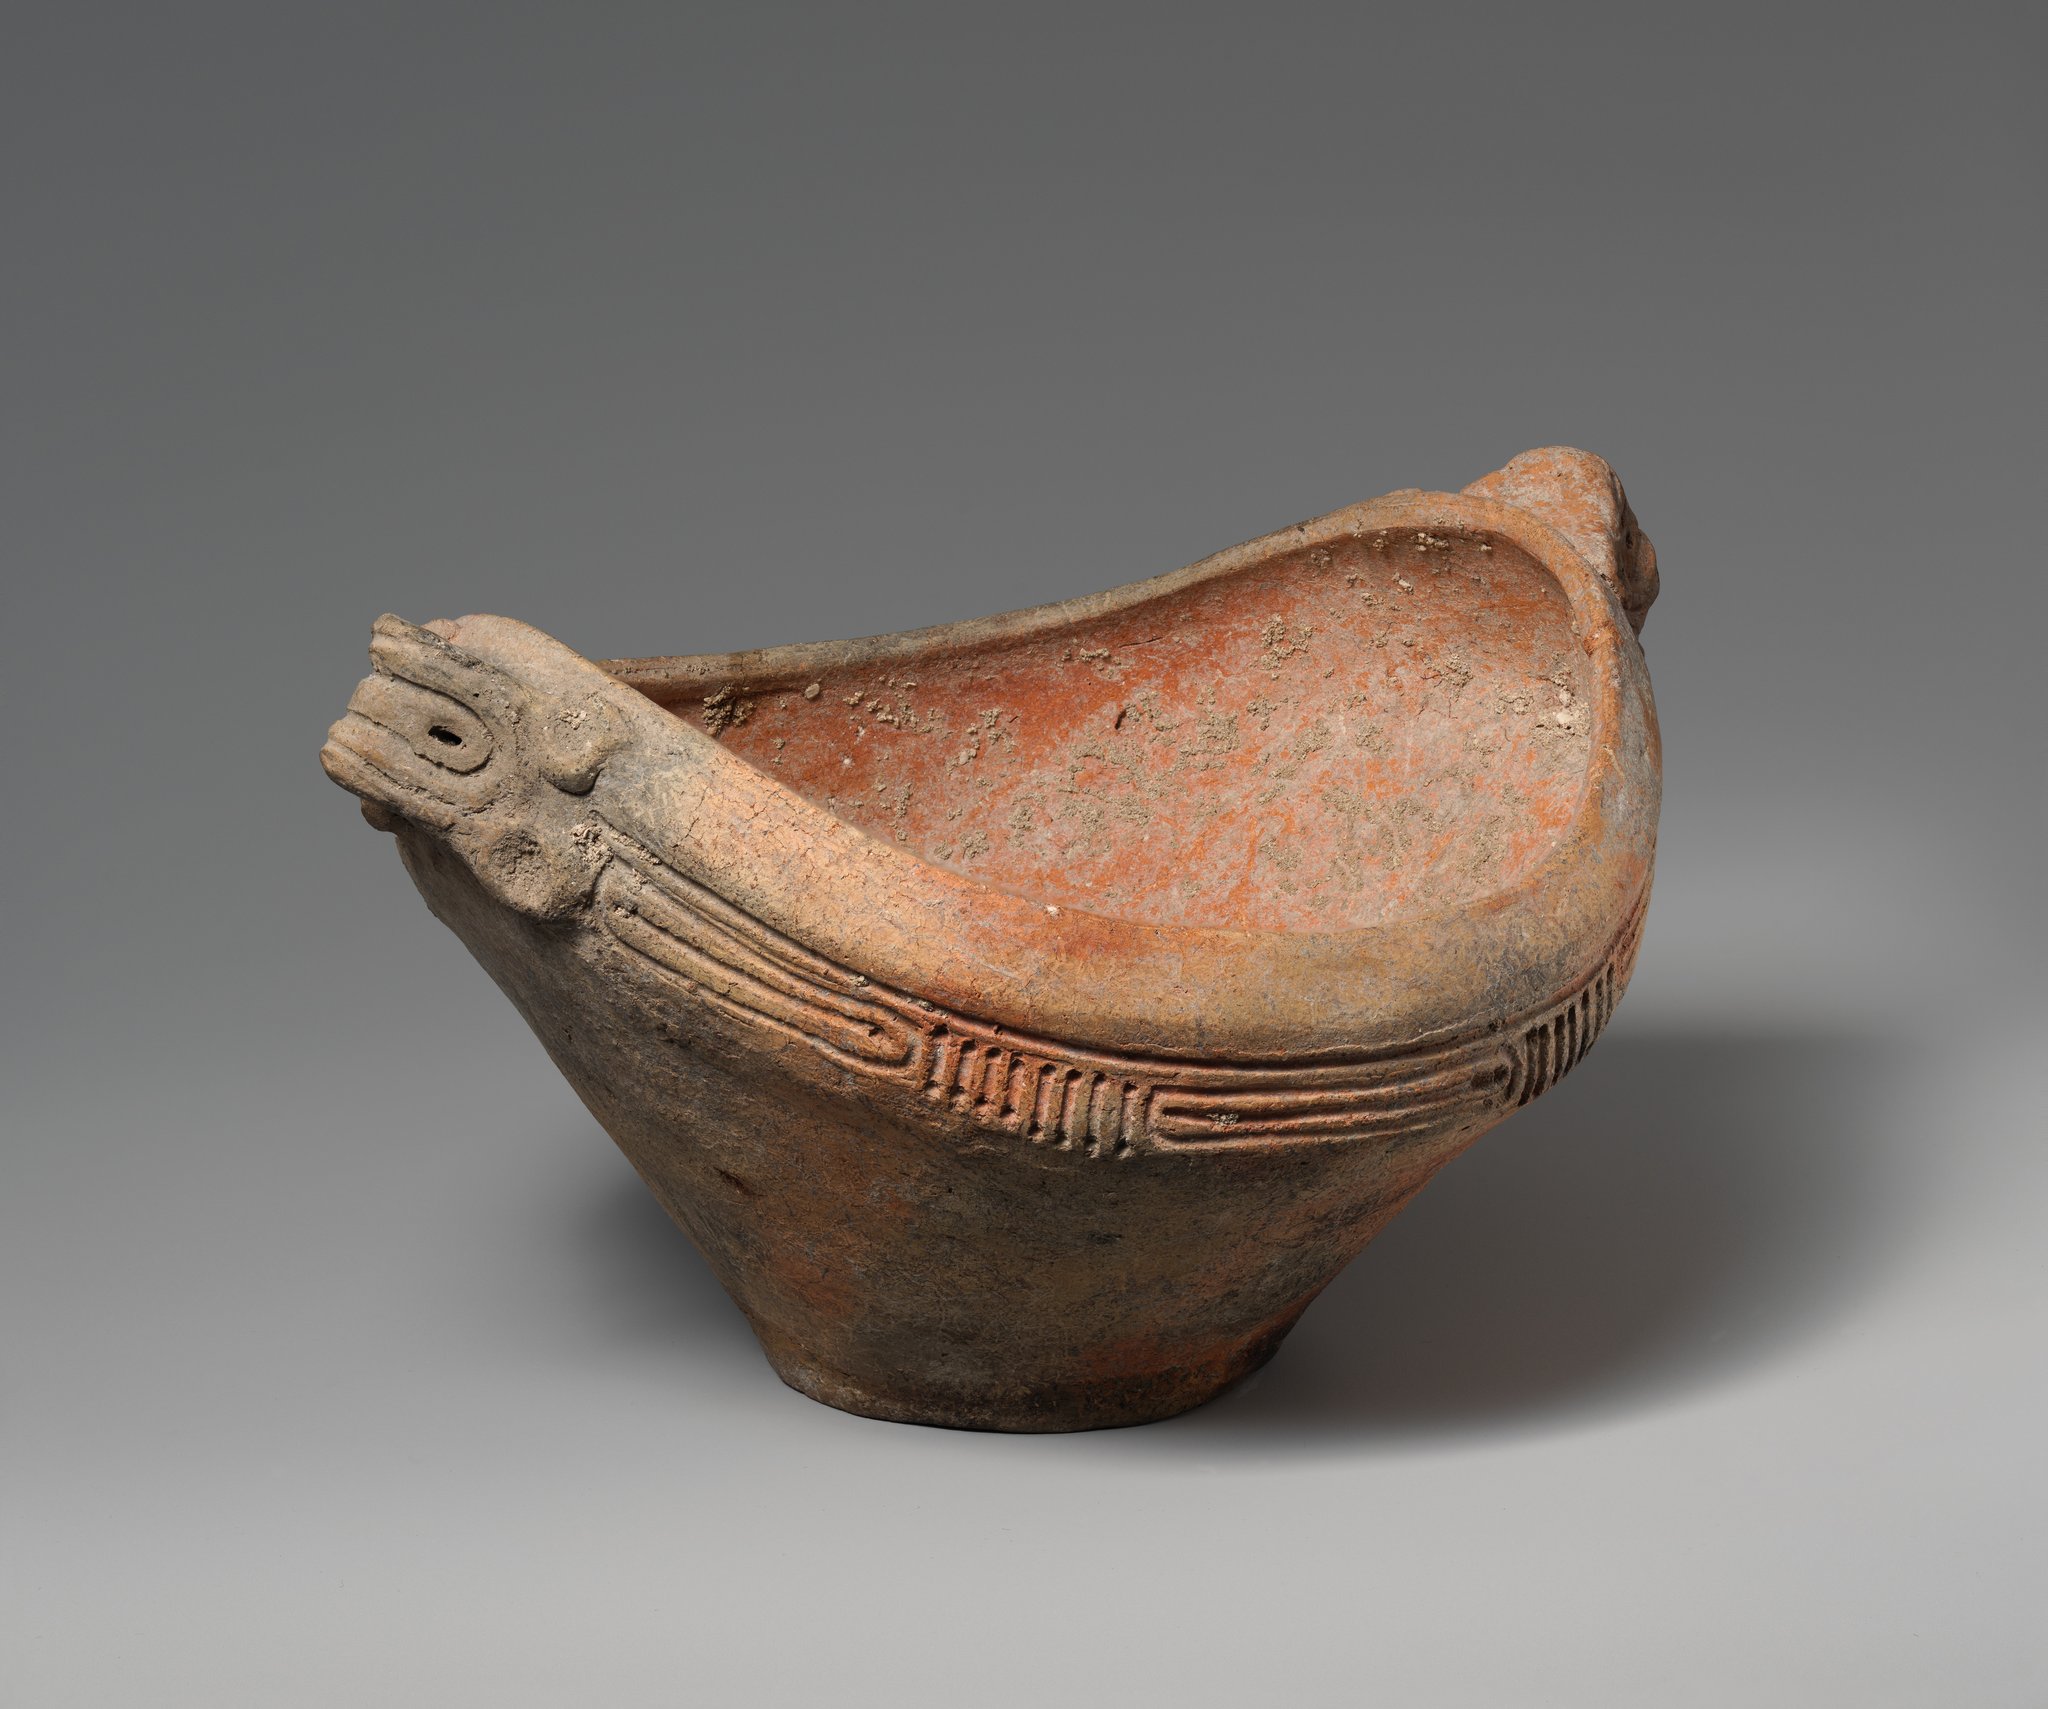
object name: bowl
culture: taíno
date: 1201-1500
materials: ceramic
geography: dominican republic